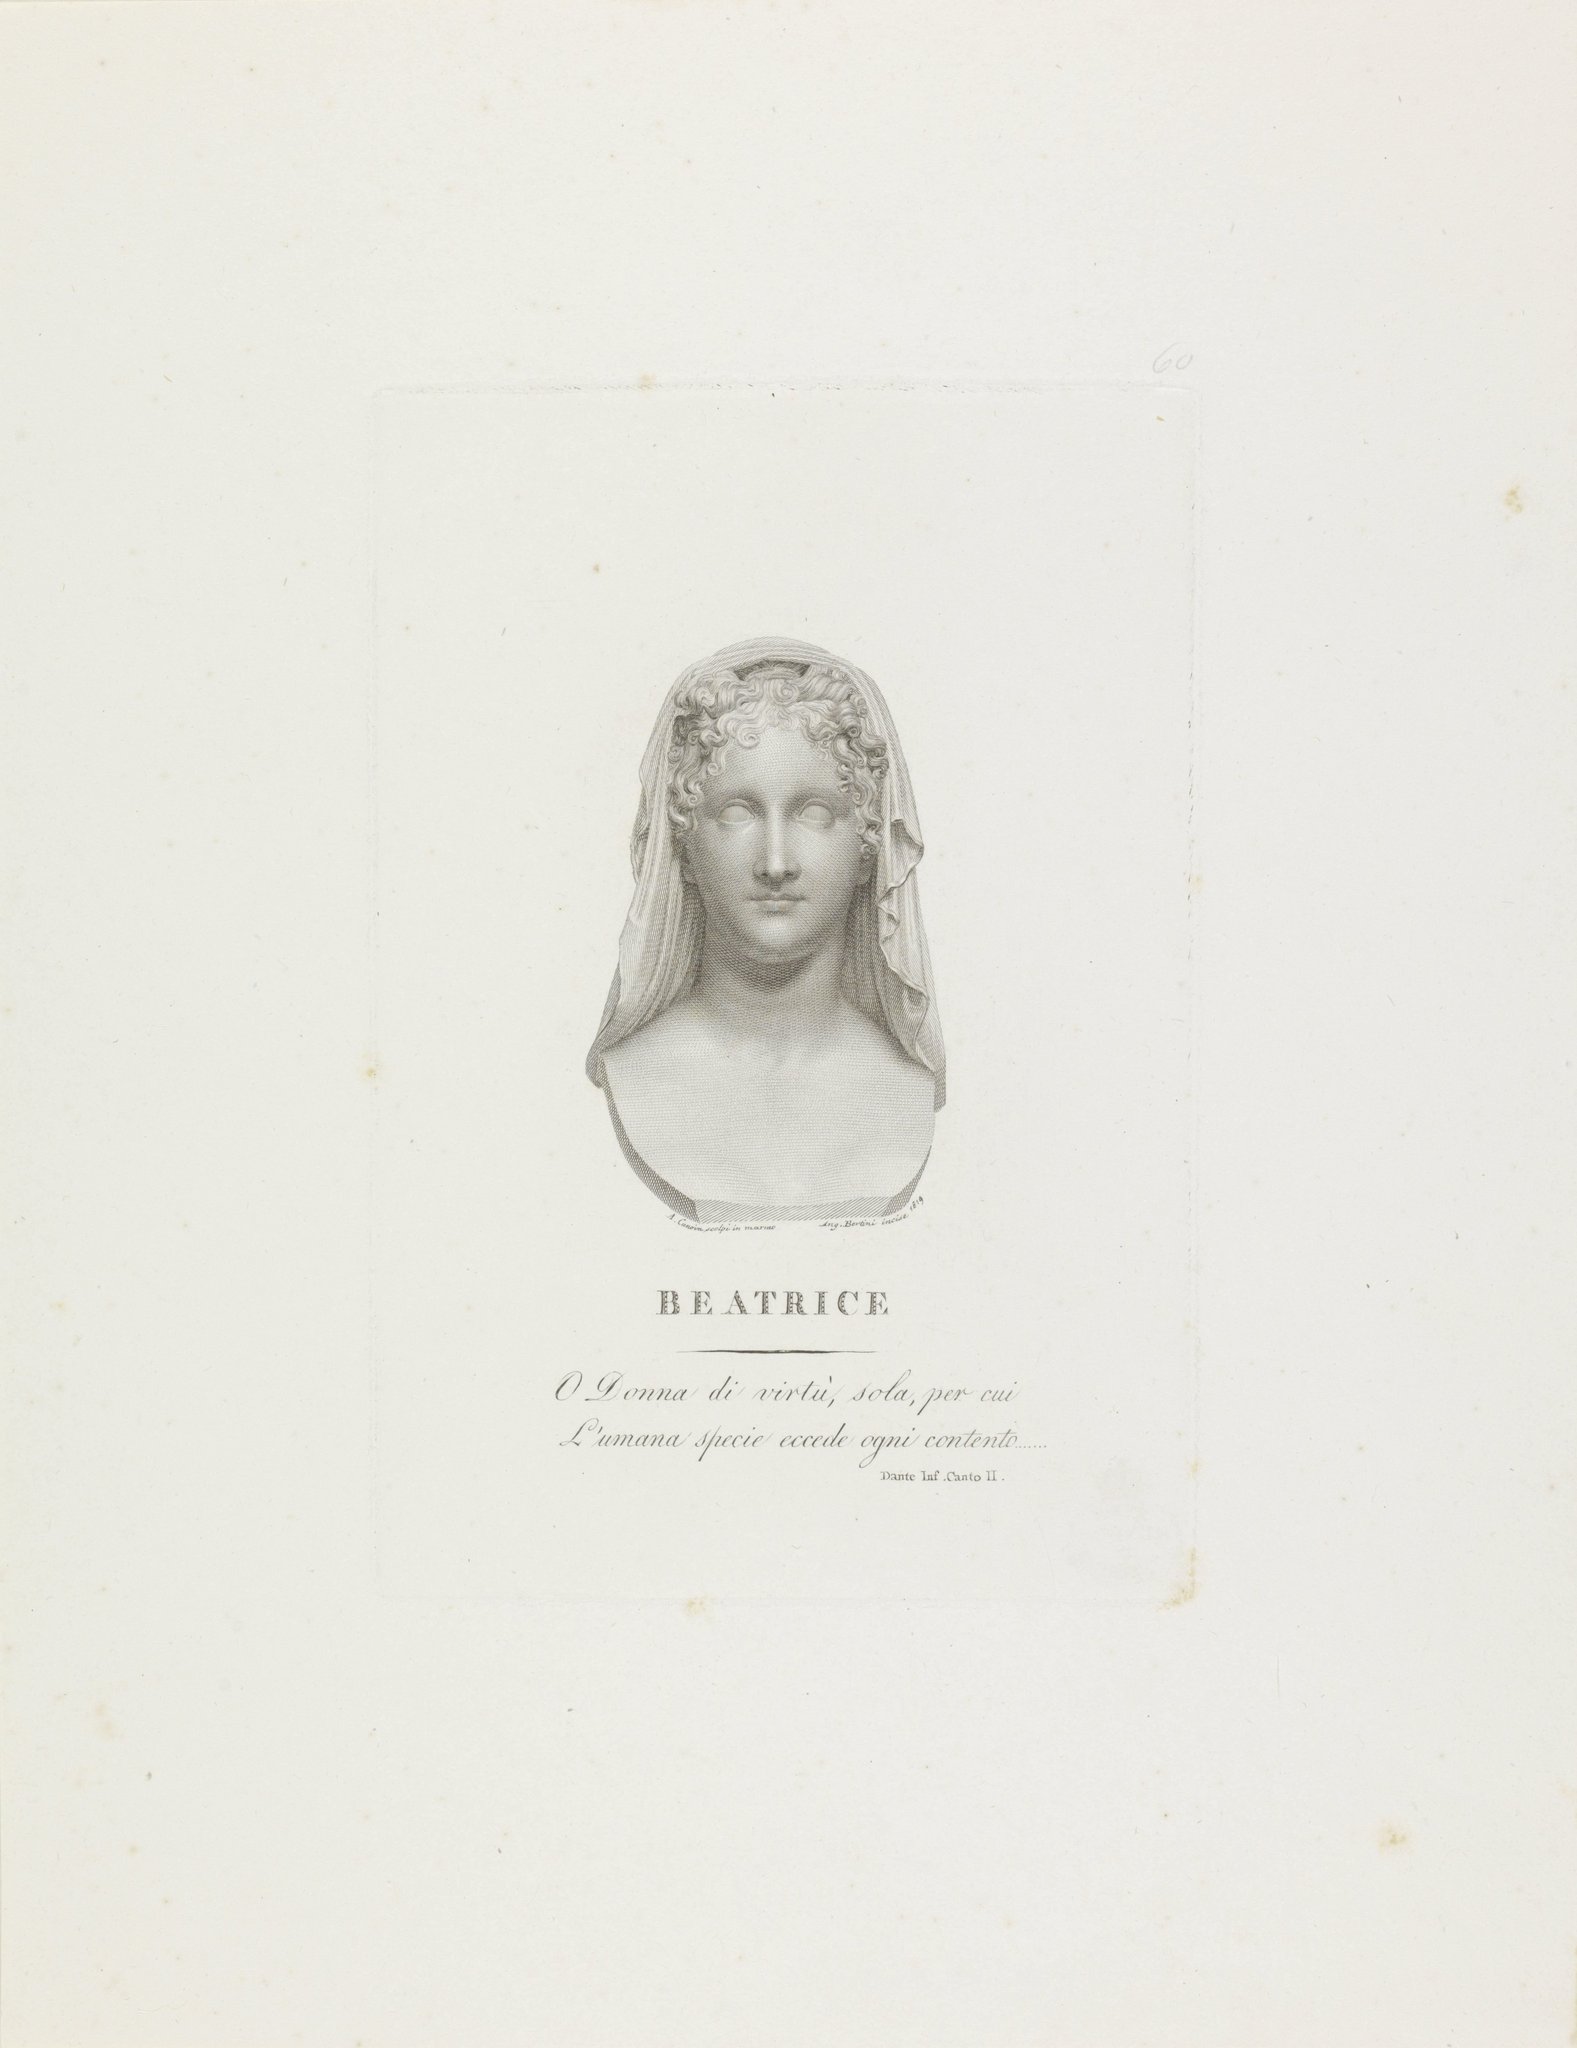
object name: print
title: Portretbuste van Beatrice Portinari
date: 1819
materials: paper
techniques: engraving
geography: italy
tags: historical persons, piece of sculpture, reproduction of a piece of sculpture, beatrice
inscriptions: collector's mark: Lugt 12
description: Gebeeldhouwde portretbuste van Beatrice Portinari, de muze van de dichter Dante Alighieri, door de Italiaanse beeldhouwer Antonio Canova.